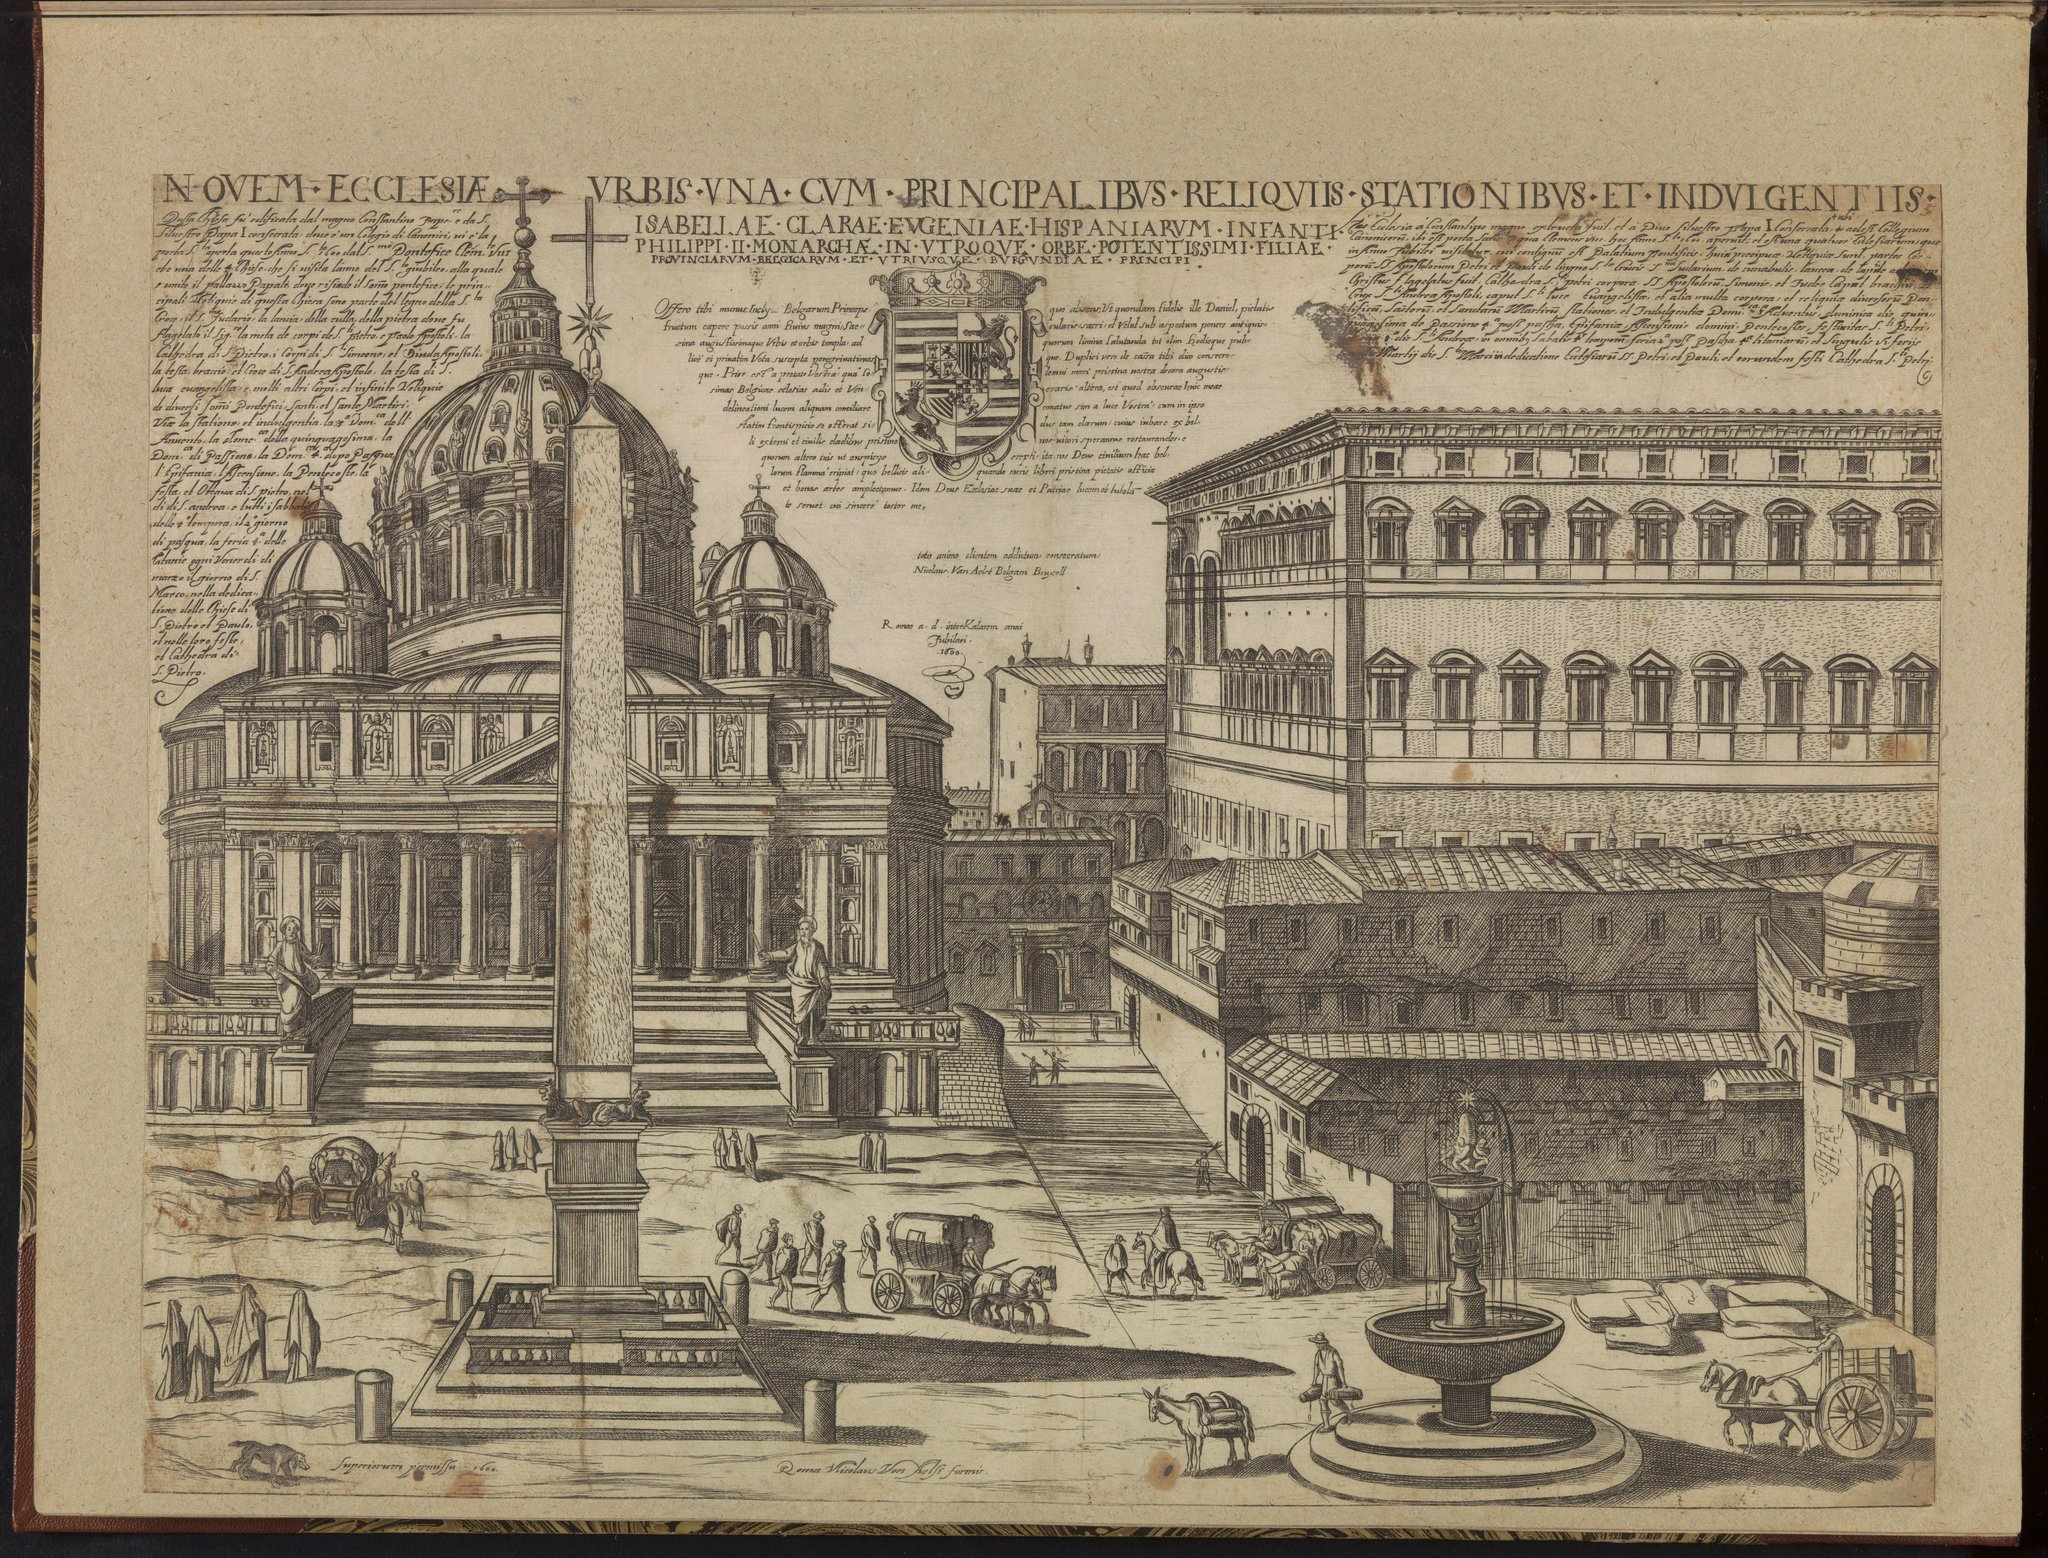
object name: print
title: Novem ecclesiae urbis una cum principalibus reliquiis stationibus et indulgentiis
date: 1600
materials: paper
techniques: etching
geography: rome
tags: obelisk, needle, palace, church (exterior), roman catholic church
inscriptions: date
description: Gezicht op de Sint-Pietersbasiliek. Rechts het Apostolisch Paleis. Op de voorgrond staat de Vaticaanse Obelisk. De prent maakt deel uit van een album.